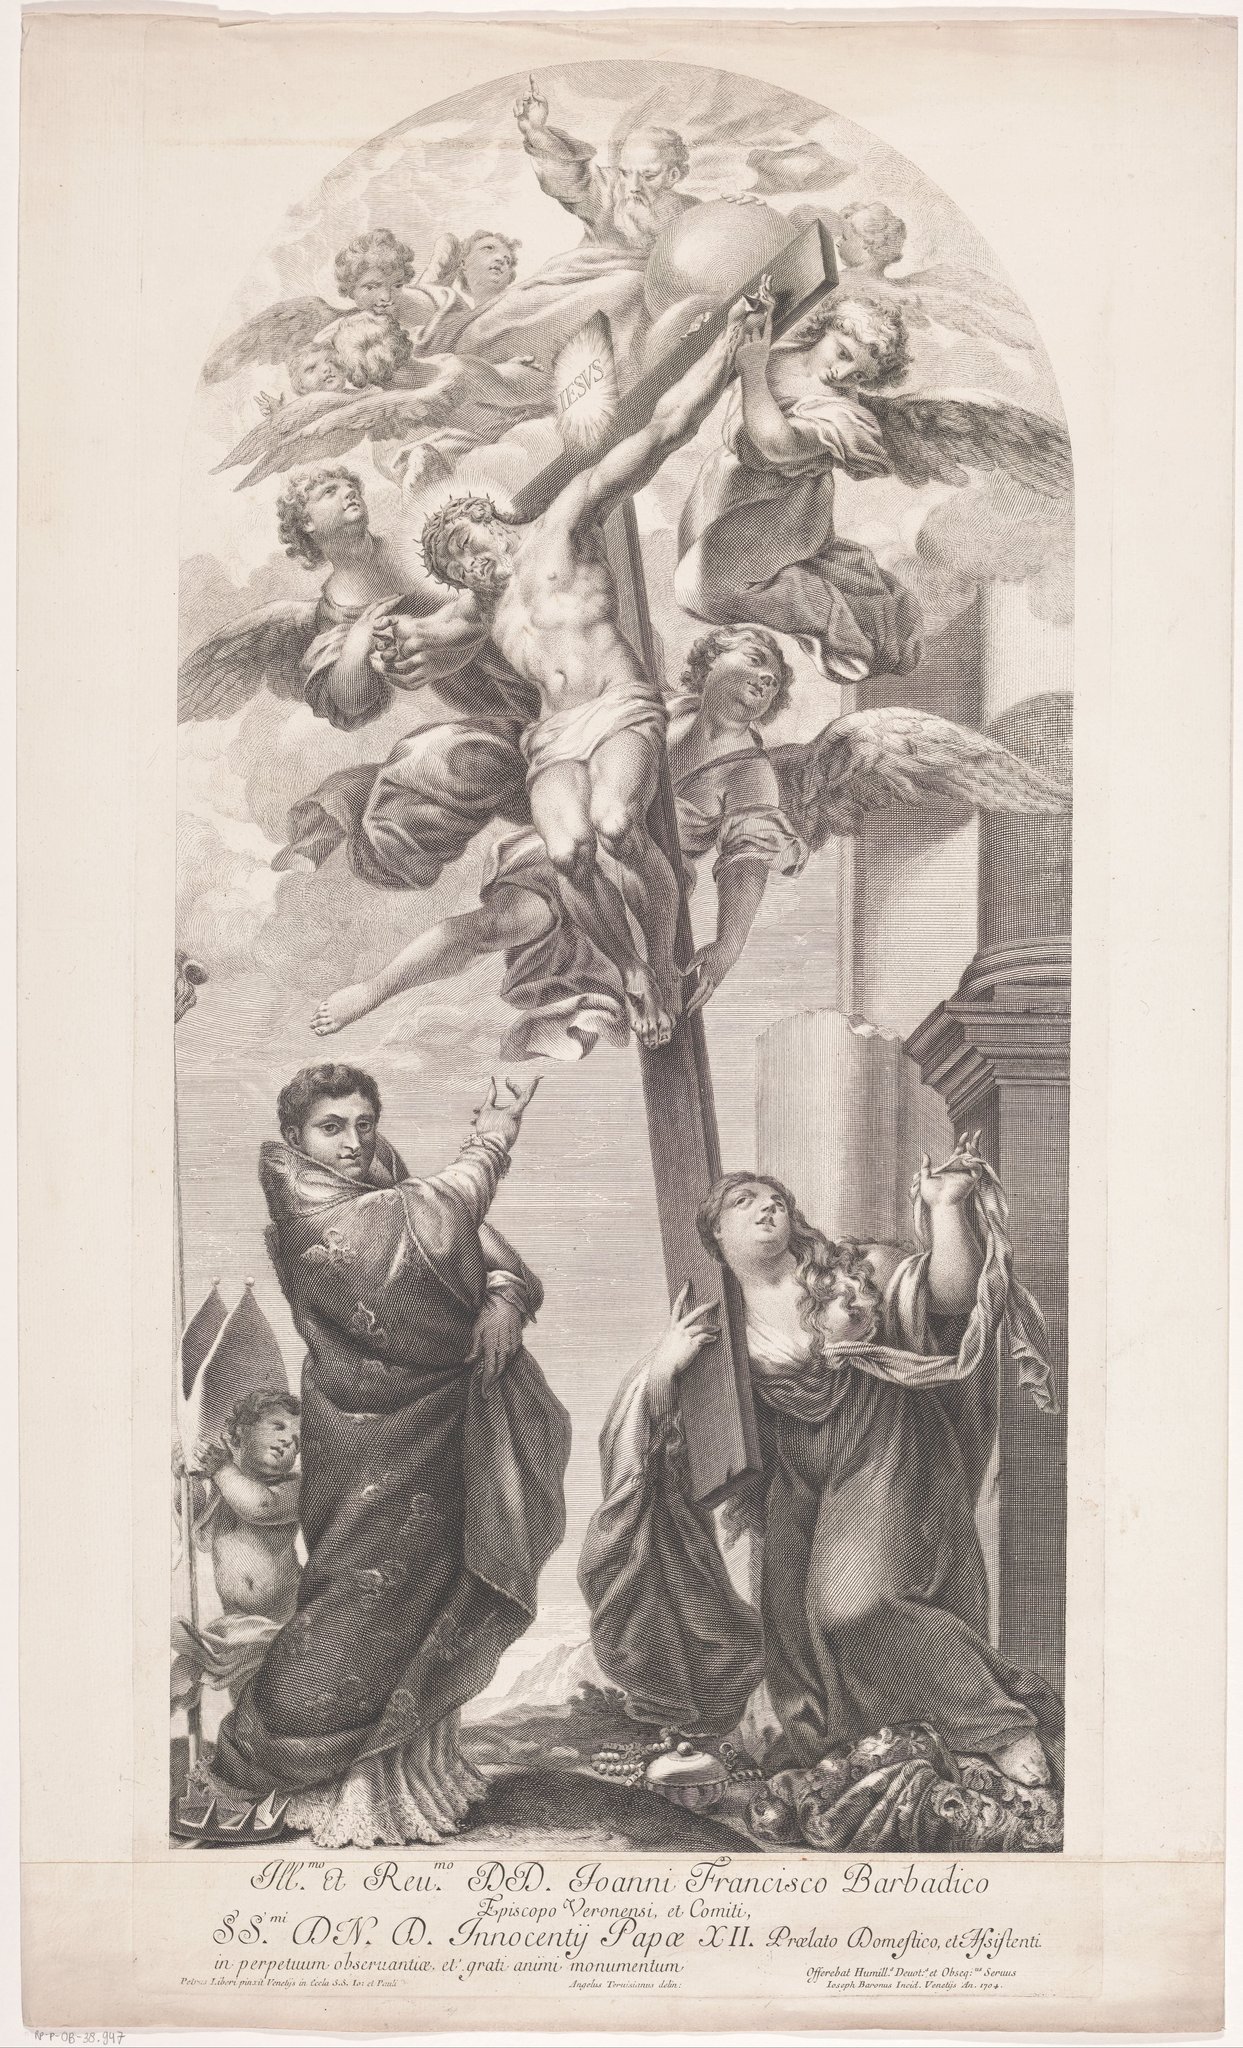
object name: print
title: Christus aan het kruis met Maria Magdalena en een bisschop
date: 1704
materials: paper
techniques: engraving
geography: italy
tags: archbishop, bishop, etc. (roman catholic), specific types of crucified christ (in non-narrative context), angels, the penitent harlot mary magdalene; possible attributes: book (or scroll), crown, crown of thorns, crucifix, jar of ointment, mirror, musical instrument, palm-branch, rosary, scourge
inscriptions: collector's mark: Lugt 240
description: Christus aan het kruis, omgeven door engelen. Aan de voet van het kruis zit Maria Magdalena. Naast het kruis staat een bisschop met daarachter een putto die zijn mijter en bisschopsstaf draagt.